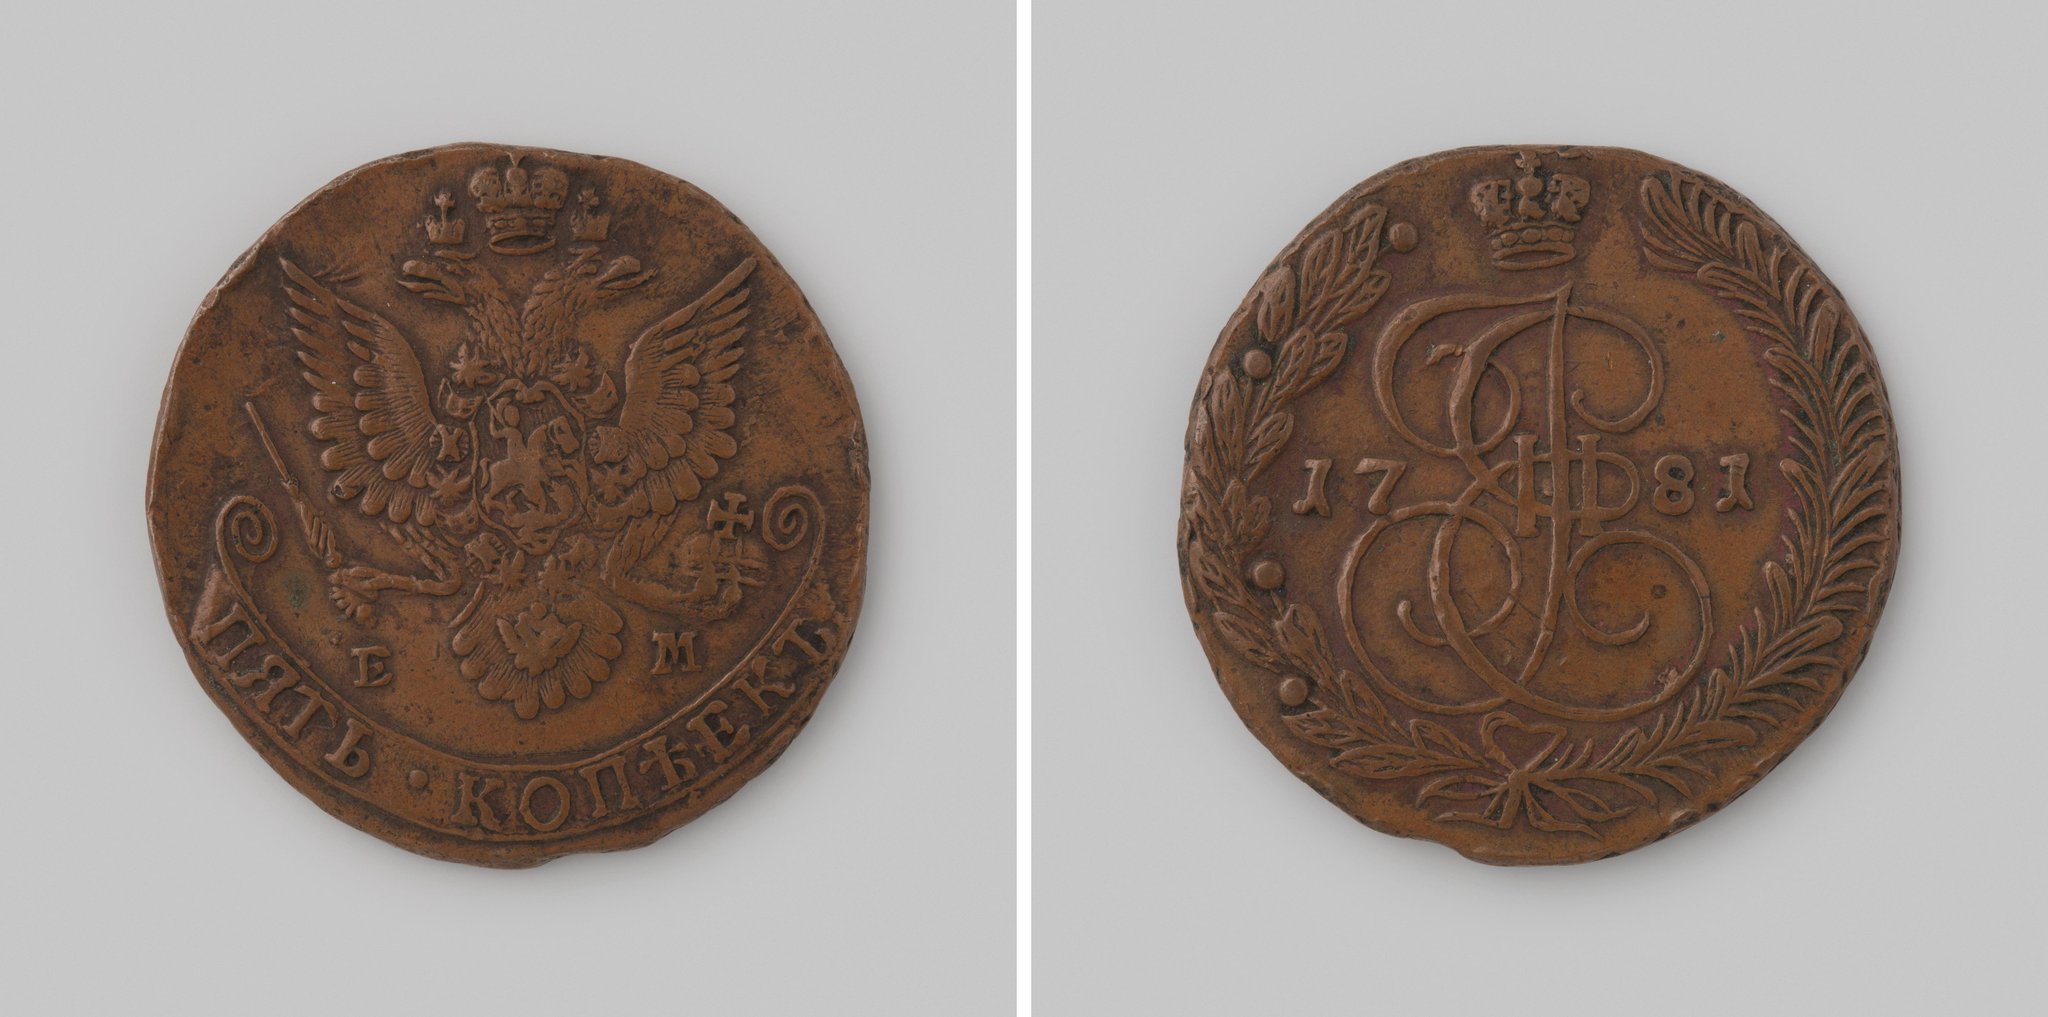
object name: coin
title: Rusland, Catherina II, 5 kopeken, 1781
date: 1781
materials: copper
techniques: striking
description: Koperen munt. Voorzijde: dubbelkoppige gekroonde adelaar met gespreide vleugels, met op zijn borst door ridderorde omhangen wapenschild en met in zijn poten scepter en bol met daarop kruis. Boven de adelaar een kroon. Links en rechts onder de staart de letters E M [=Ekaterinenburg]. Onderaan op een banderol waarde-aanduiding. Keerzijde: binnen twee samengebonden takken tussen het jaartal gekroond monogram van de czarina. Kabelrand.